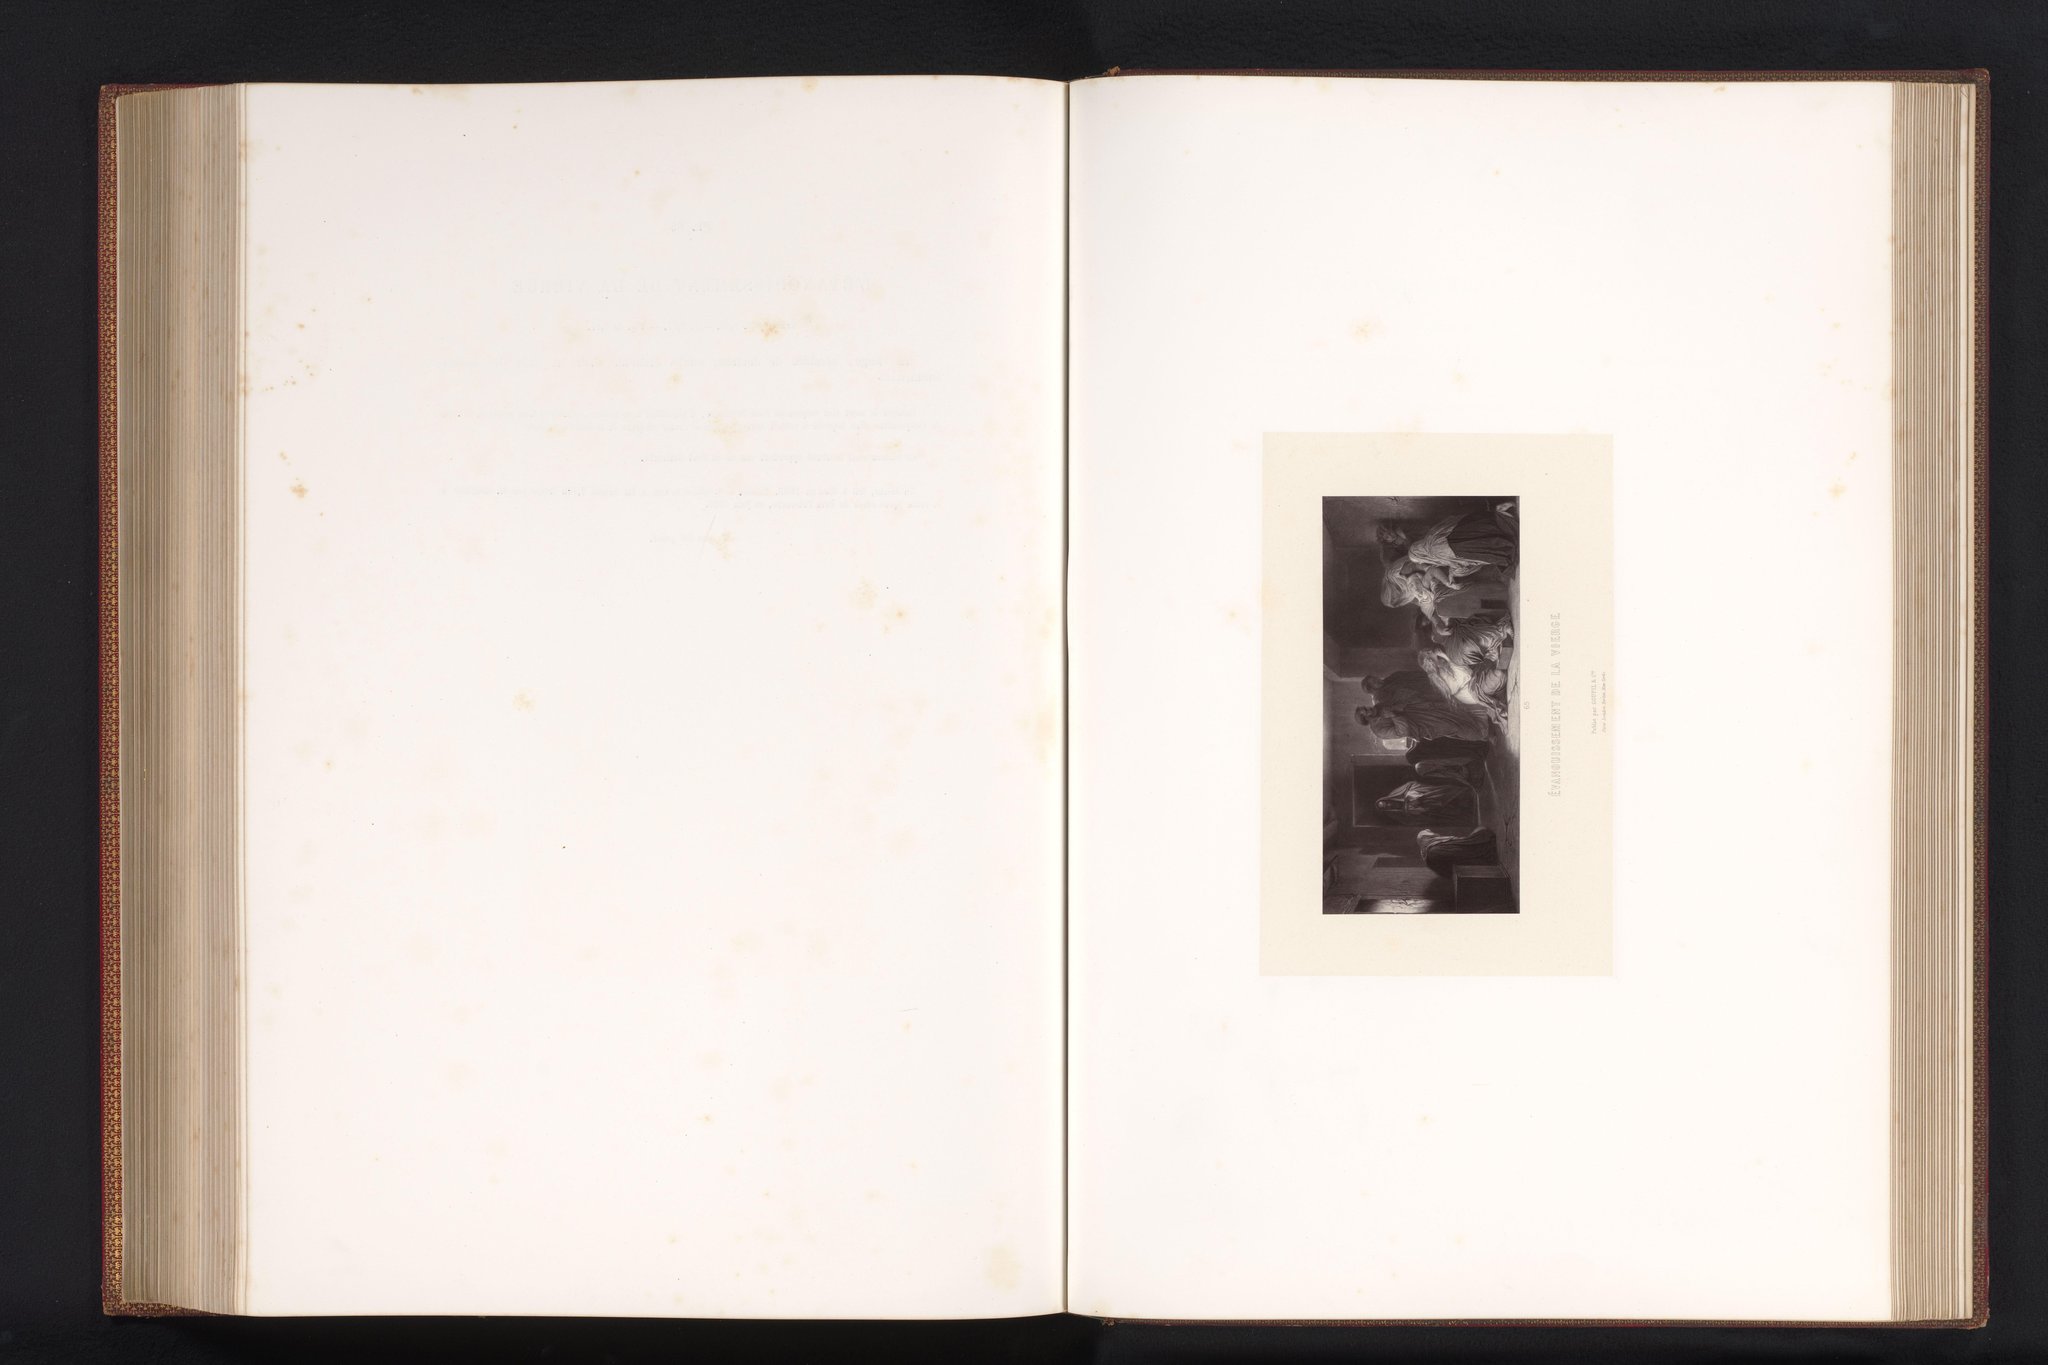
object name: page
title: L'évanouissement de la Vierge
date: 1853-1858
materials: paper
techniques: albumen print, engraving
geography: paris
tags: fainting, swooning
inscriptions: check stamp: ‘Goupil & Cie’